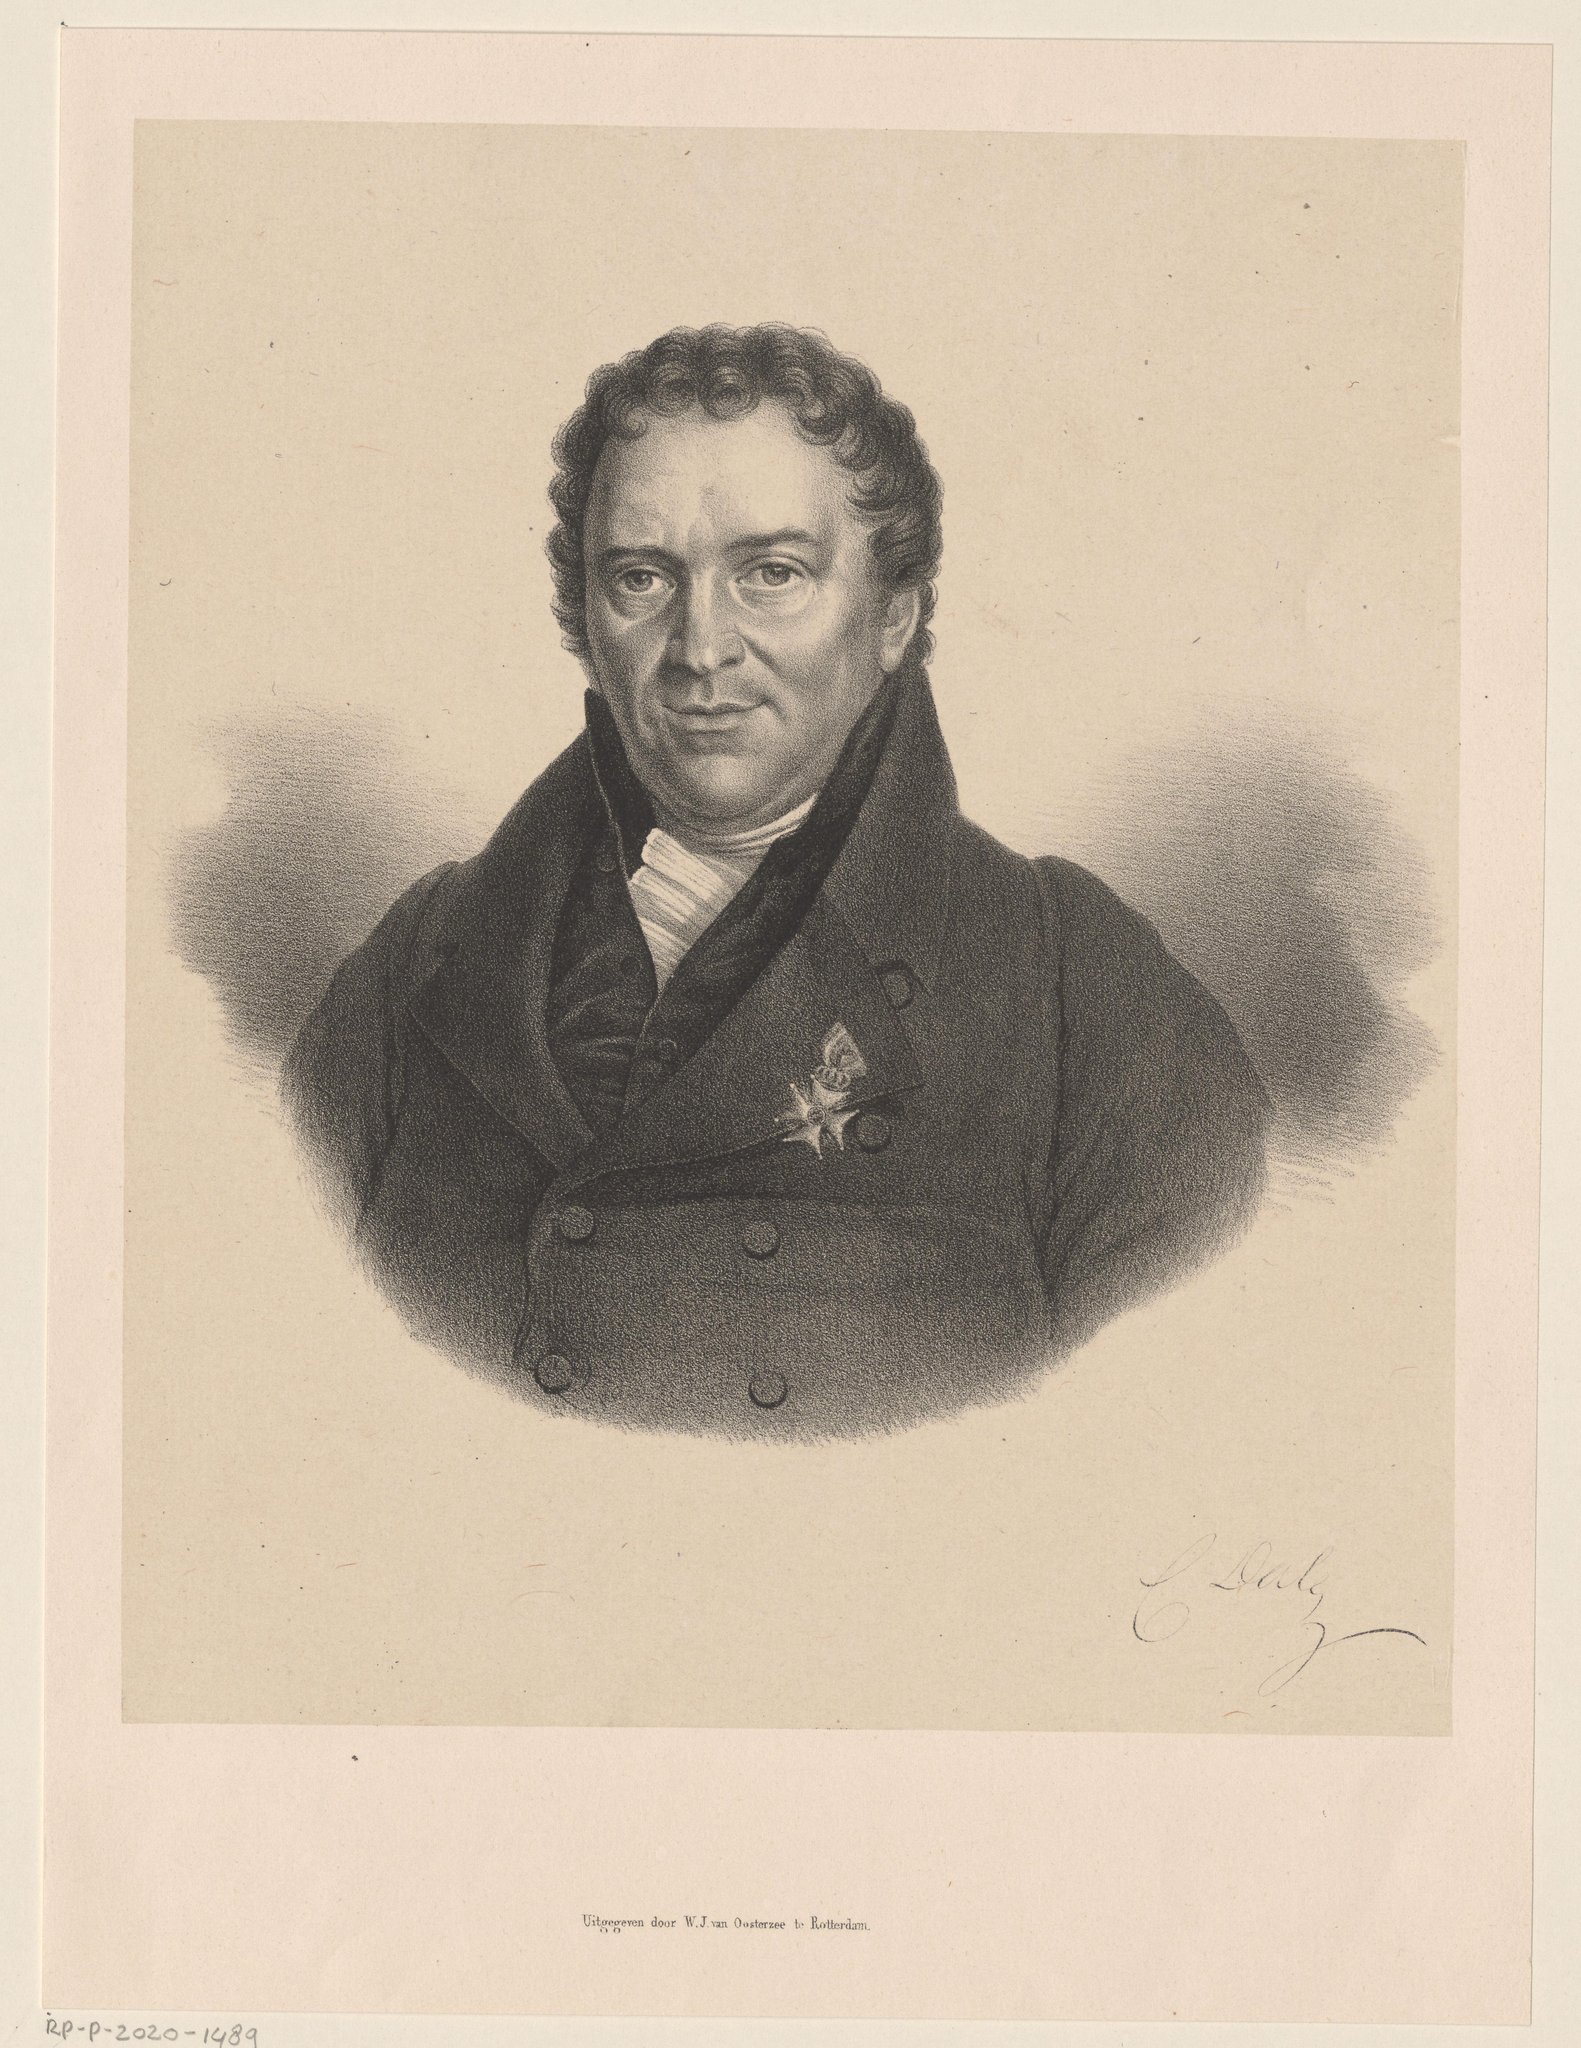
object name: print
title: Portret van Cornelis Dalen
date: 1840-1844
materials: paper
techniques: lithograph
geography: rotterdam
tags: archbishop, bishop, etc. (roman catholic), historical persons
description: Prent mogelijk gebruikt in: Khevenhüller, Franz Christoph von. Annales Ferdinandei (...). 12 dln. Leipzig: Moritz Georg Weidmann, 1721-1726.